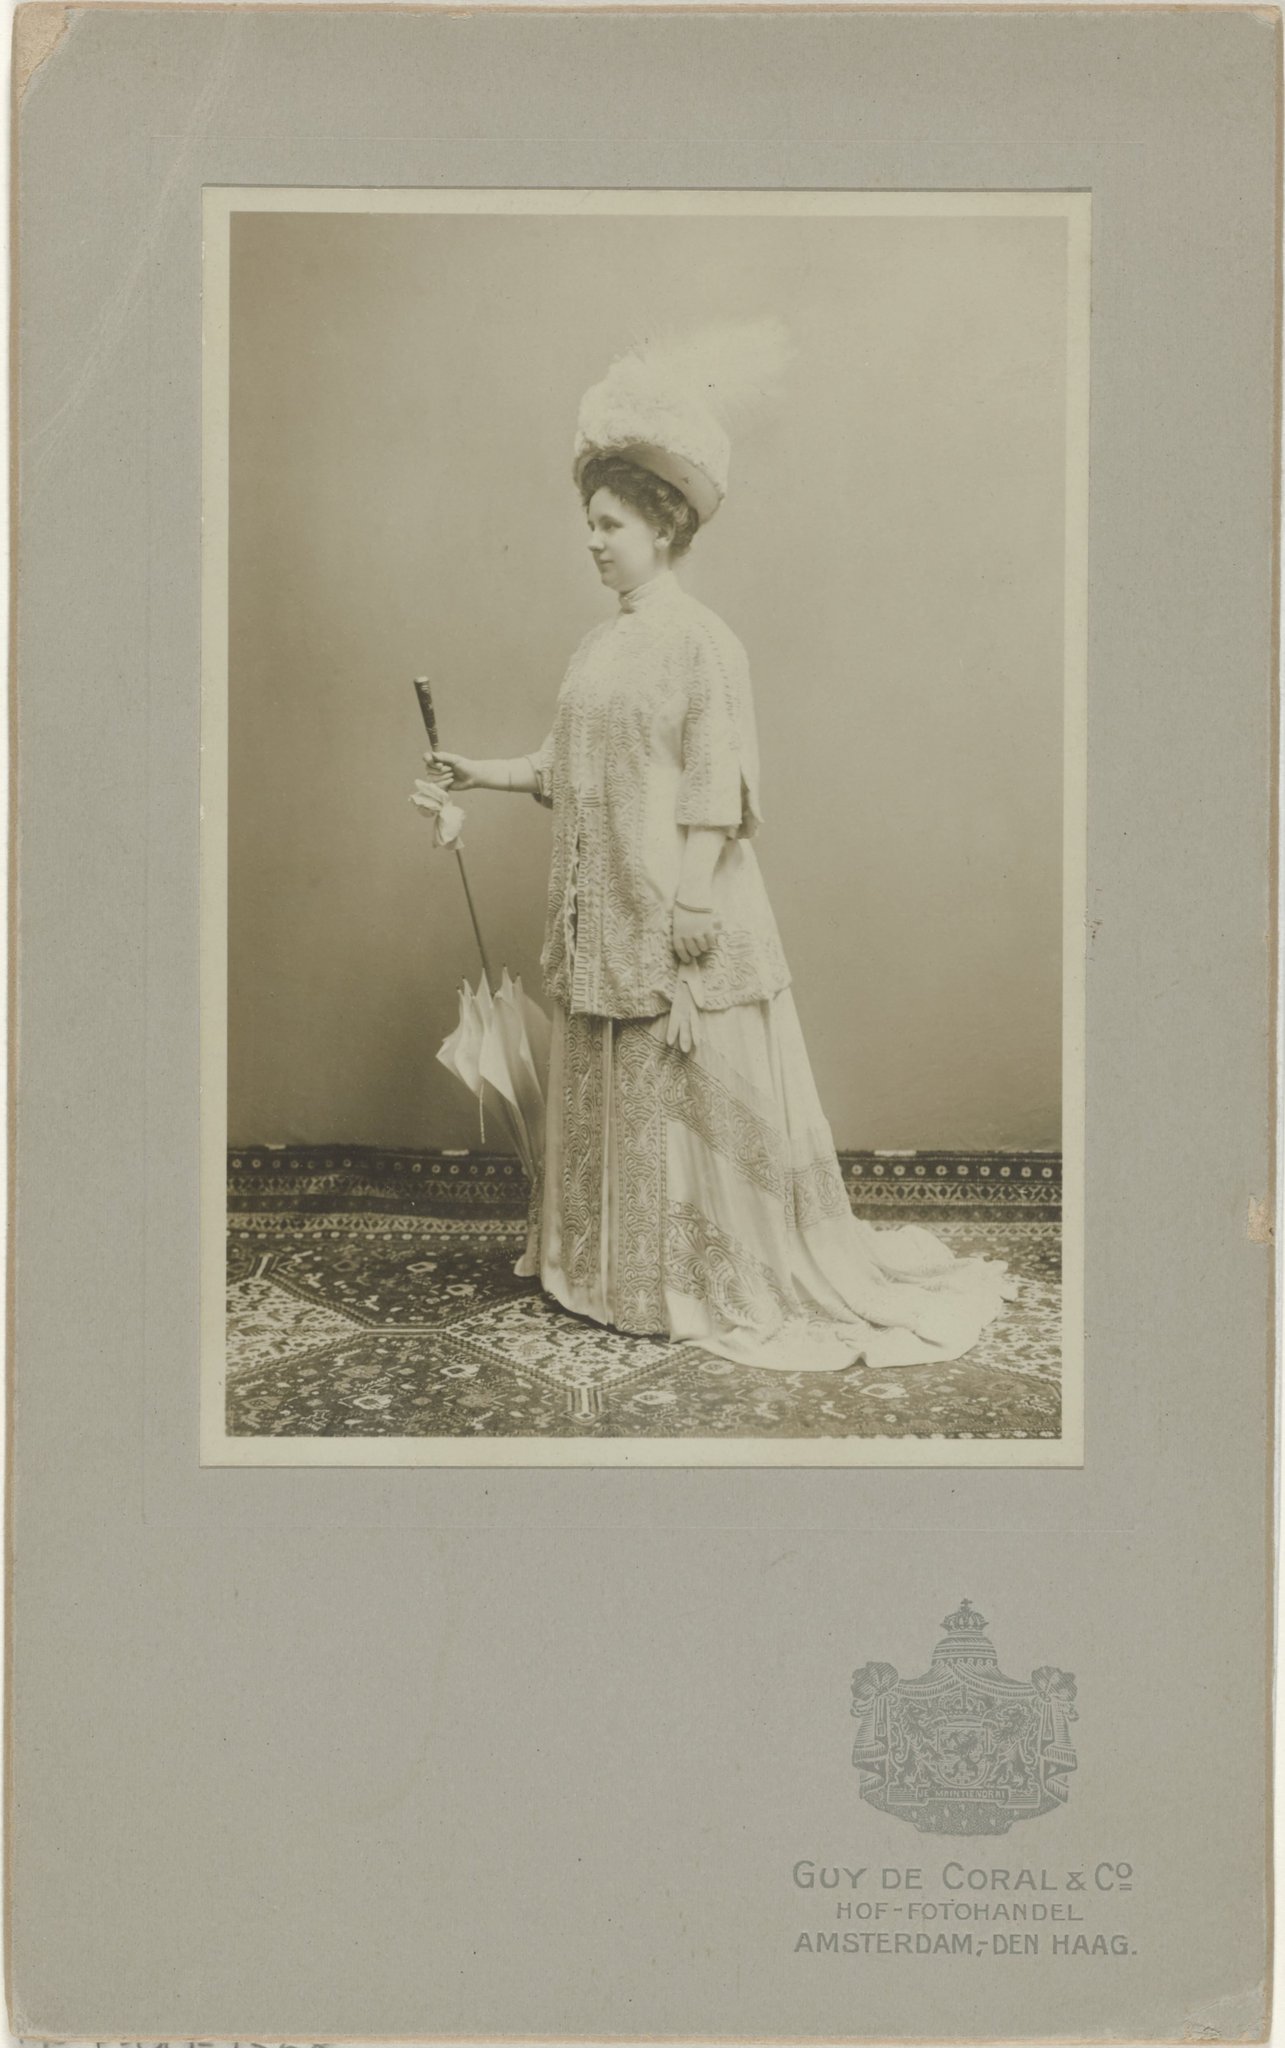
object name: photograph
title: Portret van Wilhelmina, koningin der Nederlanden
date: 1908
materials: cardboard, photographic support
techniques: photography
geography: netherlands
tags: the hague, print maker, wilhelmina of the netherlands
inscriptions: address: ‘Guy de Coral & Co HOF-FOTOHANDEL AMSTERDAM-DEN HAAG.’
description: De hier vermelde titel verwijst naar de hoogst verkregen titel van de geportretteerde, niet per se naar de titel die de geportretteerde op deze voorstelling draagt.